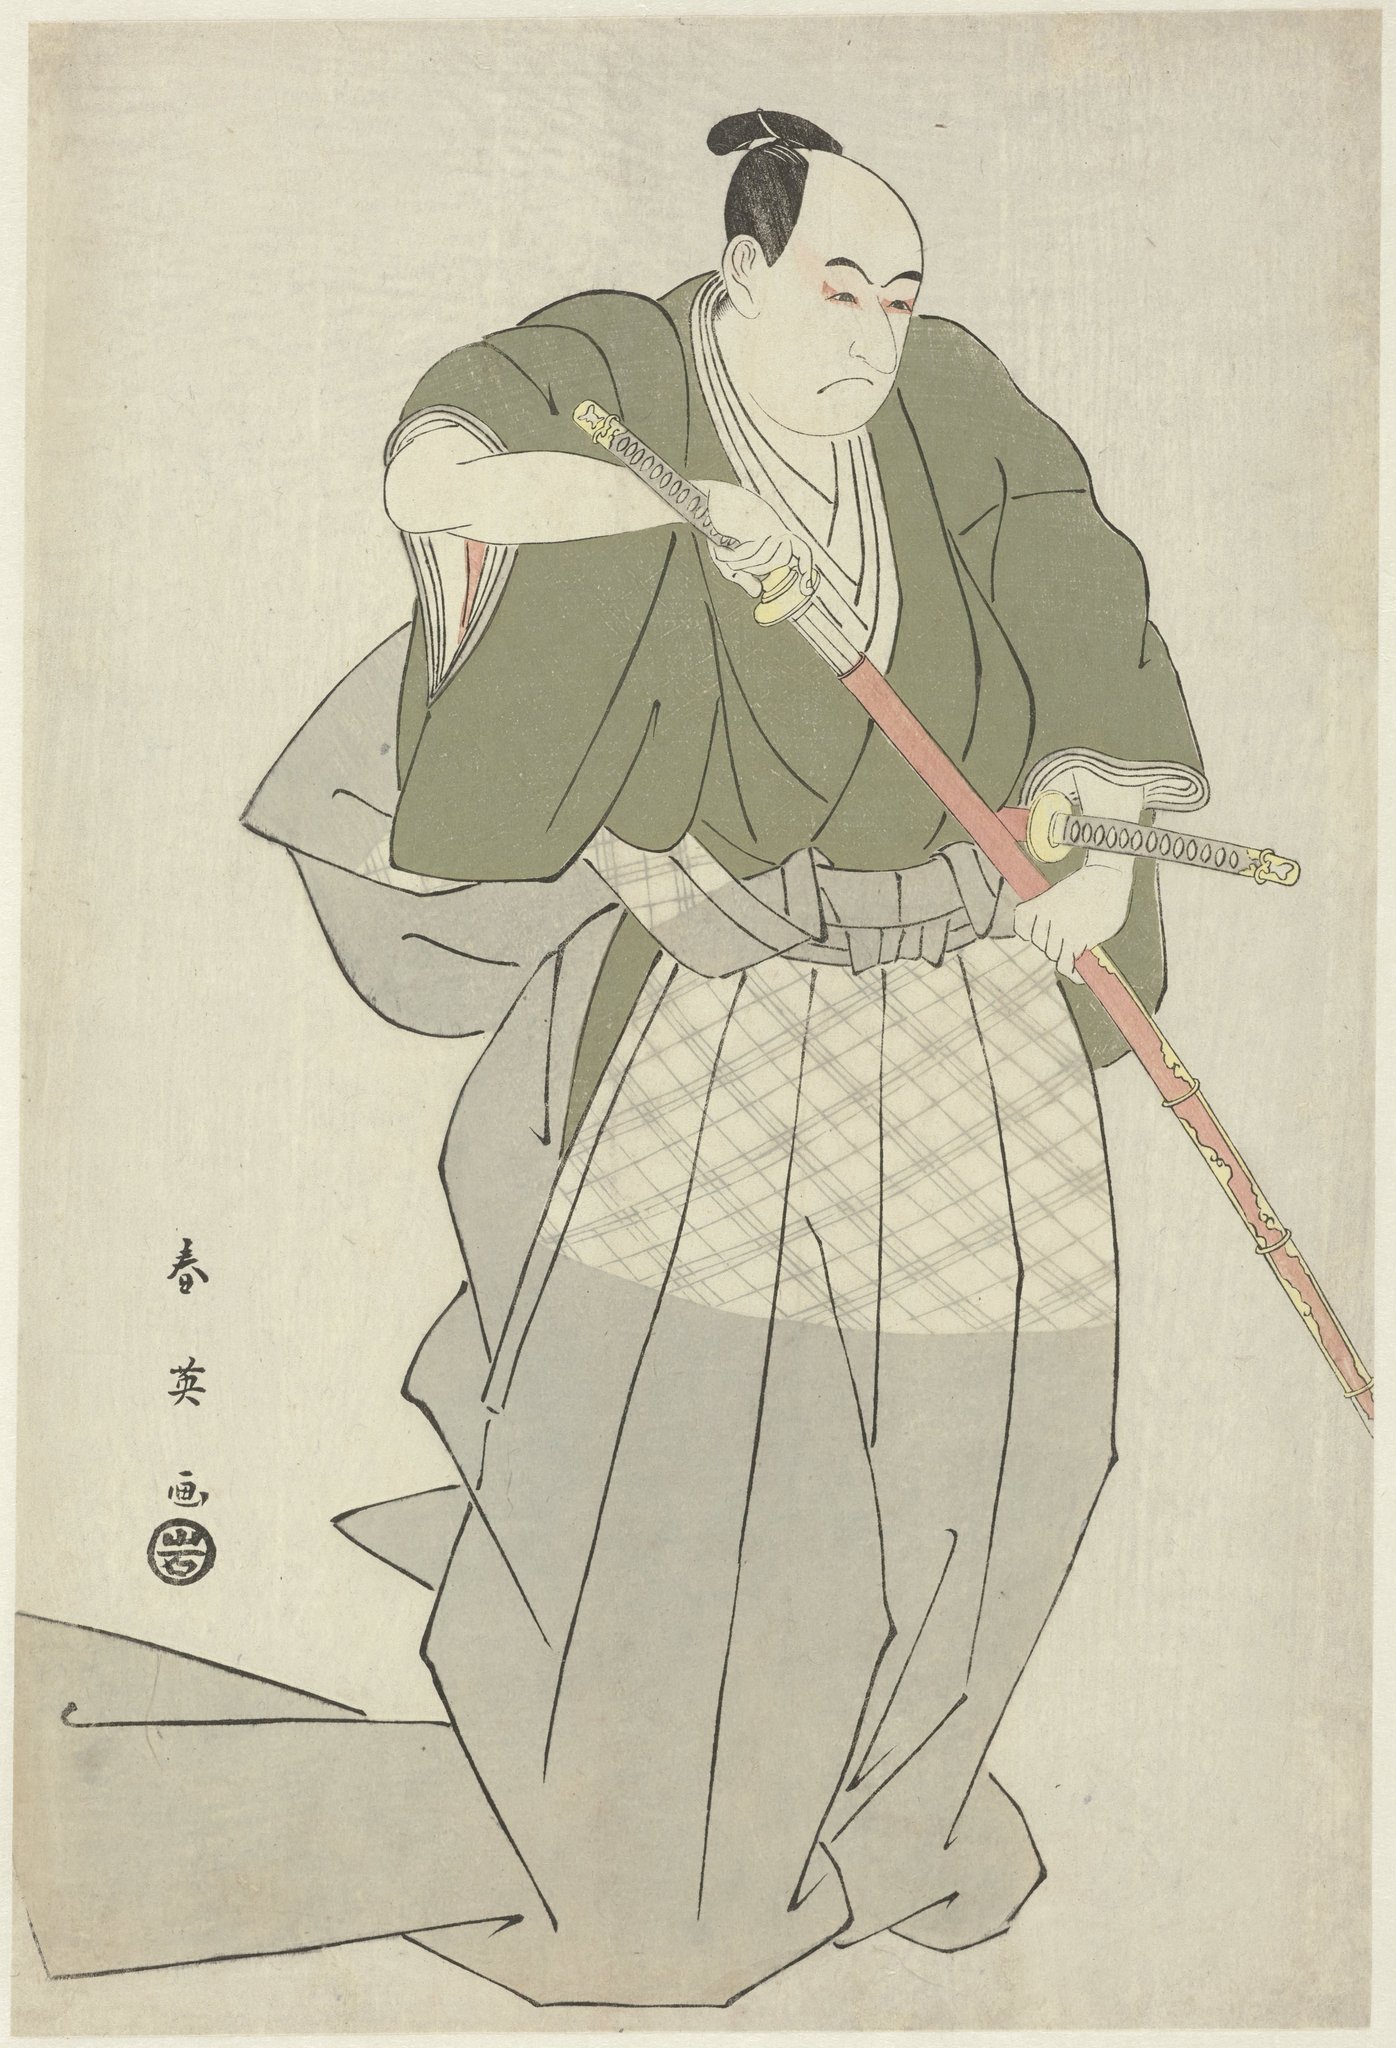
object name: print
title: Momonoi Wakasanosuke Drawing a Sword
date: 1795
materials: paper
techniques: woodcut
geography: japan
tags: hacking and thrusting weapons: sword, actor (on the stage)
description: The print features an actor in the play Chushingura. This famous Japanese saga is about 47 samurai who avenge their master’s death. The colours are well preserved. Notice, for example, the subtle red around the eyes: this make-up identifies the figure as an actor.